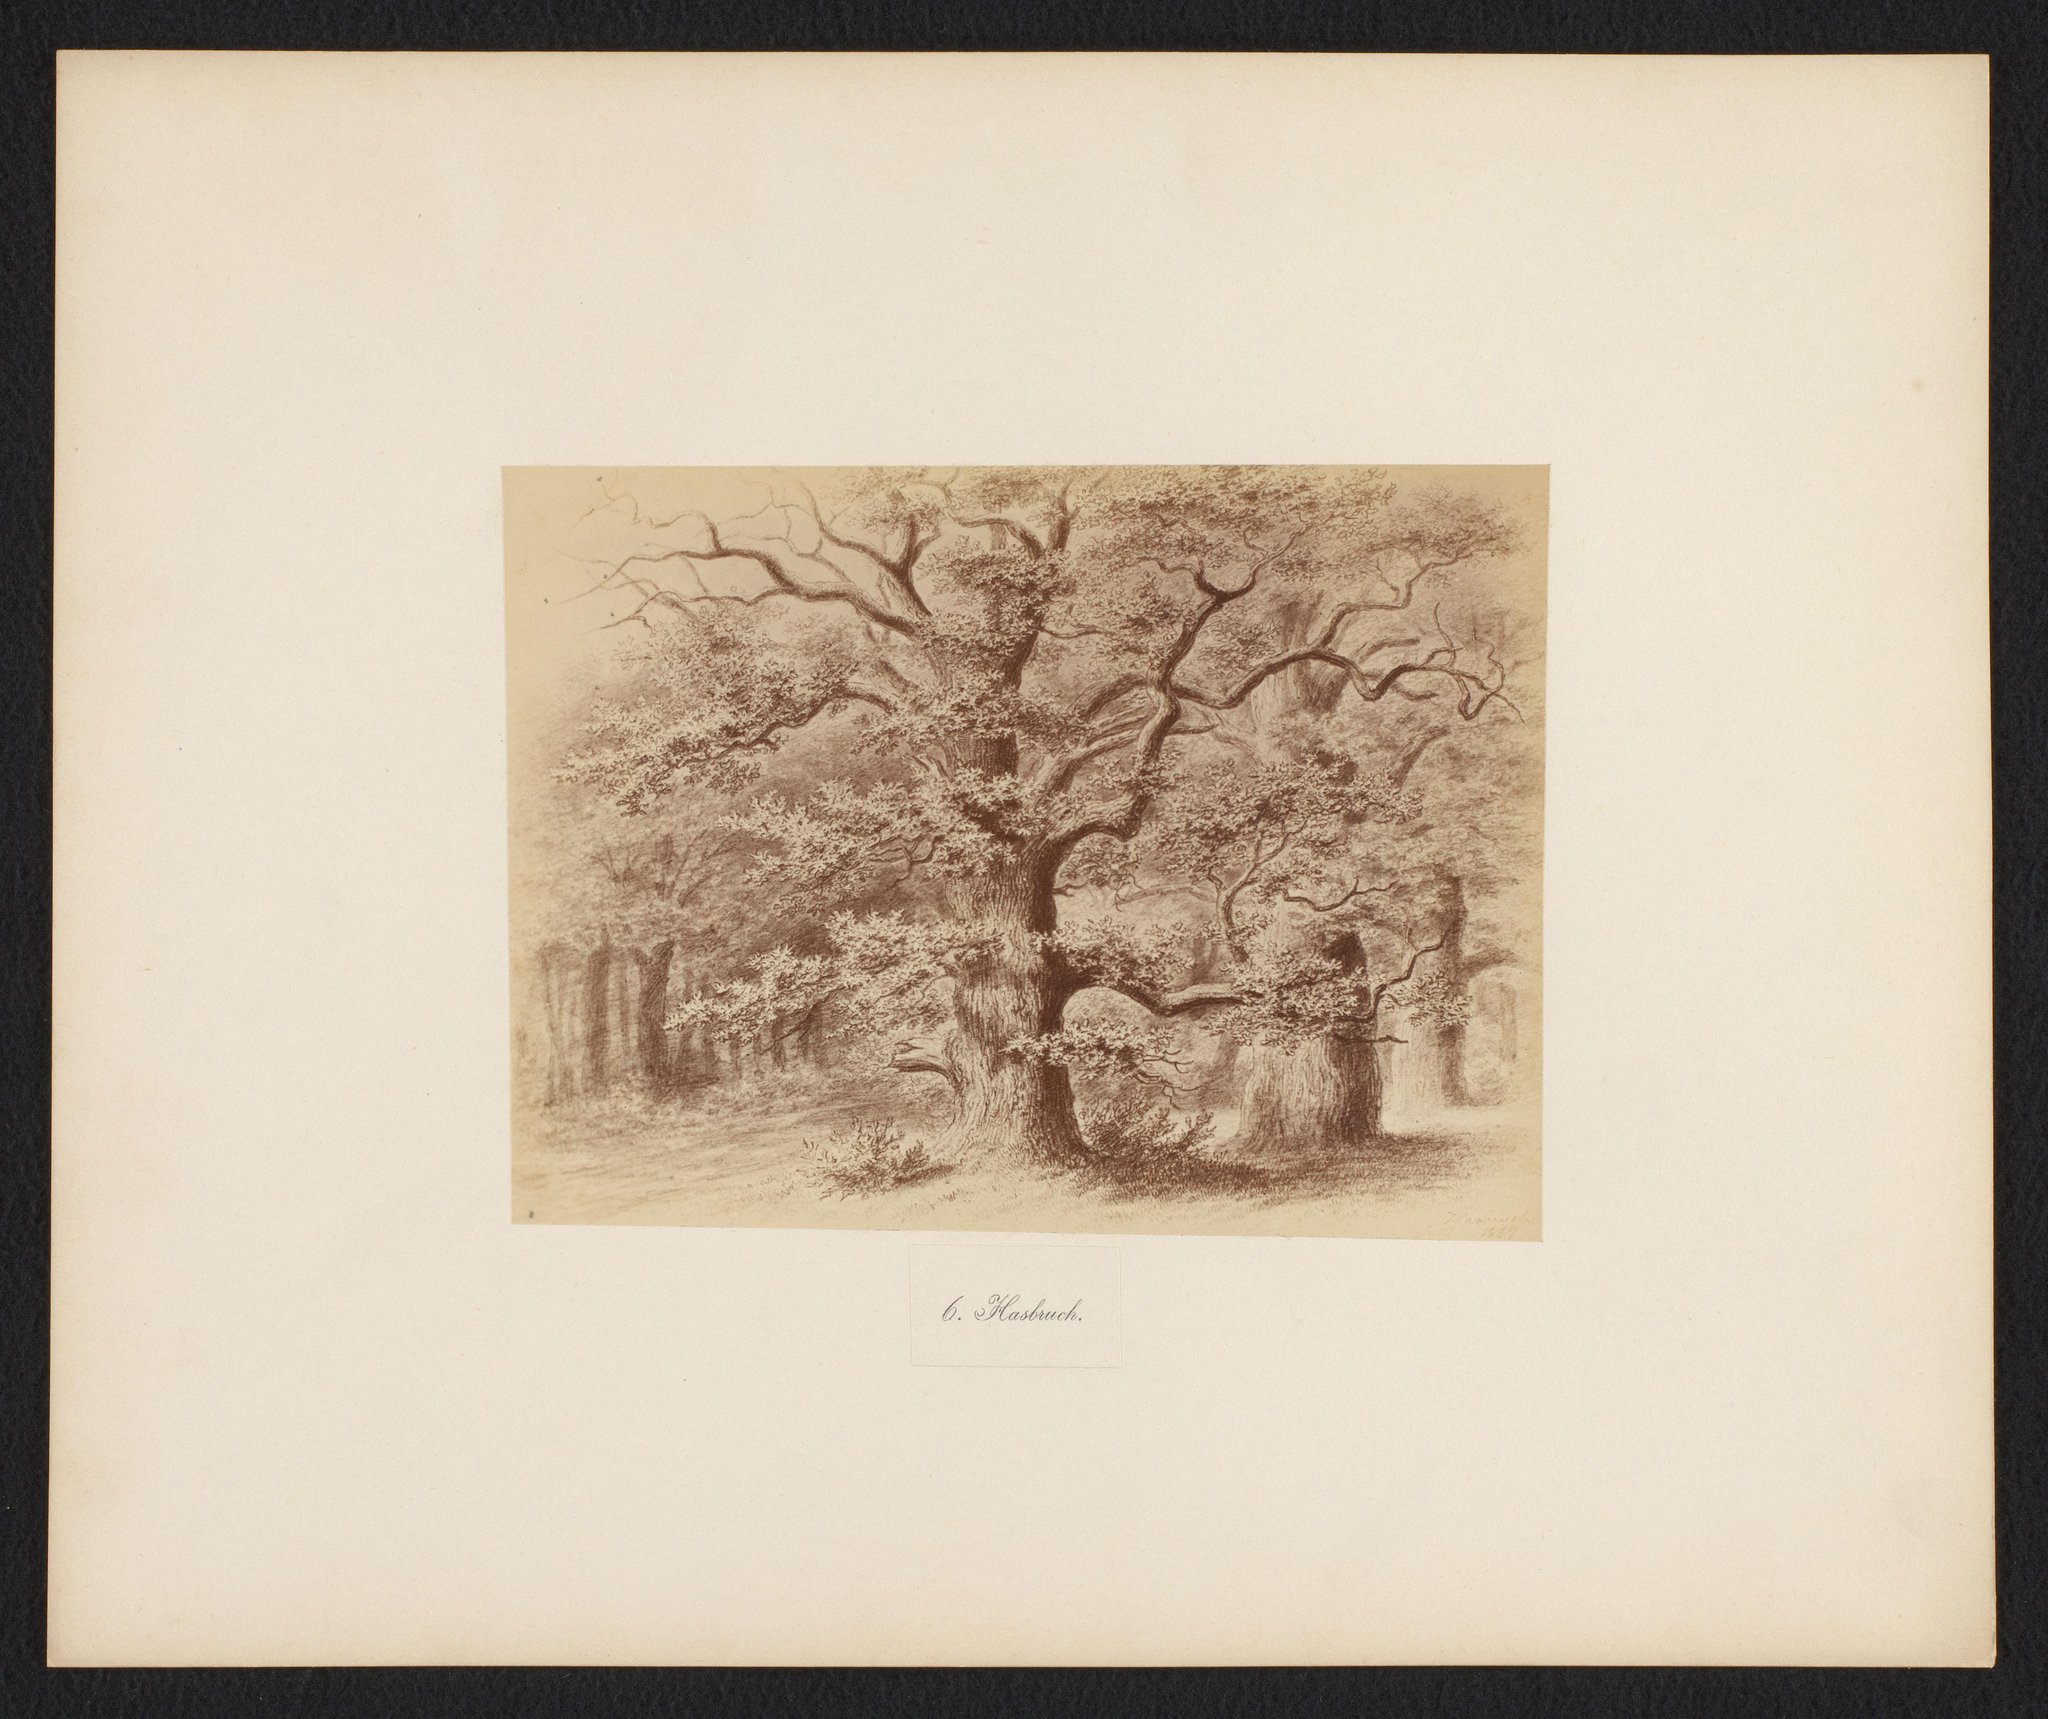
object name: reproduction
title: Fotoreproductie van een tekening van Friedrich Schad van een eik te Hasbruch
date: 1870-1875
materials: cardboard, paper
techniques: albumen print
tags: trees: oak